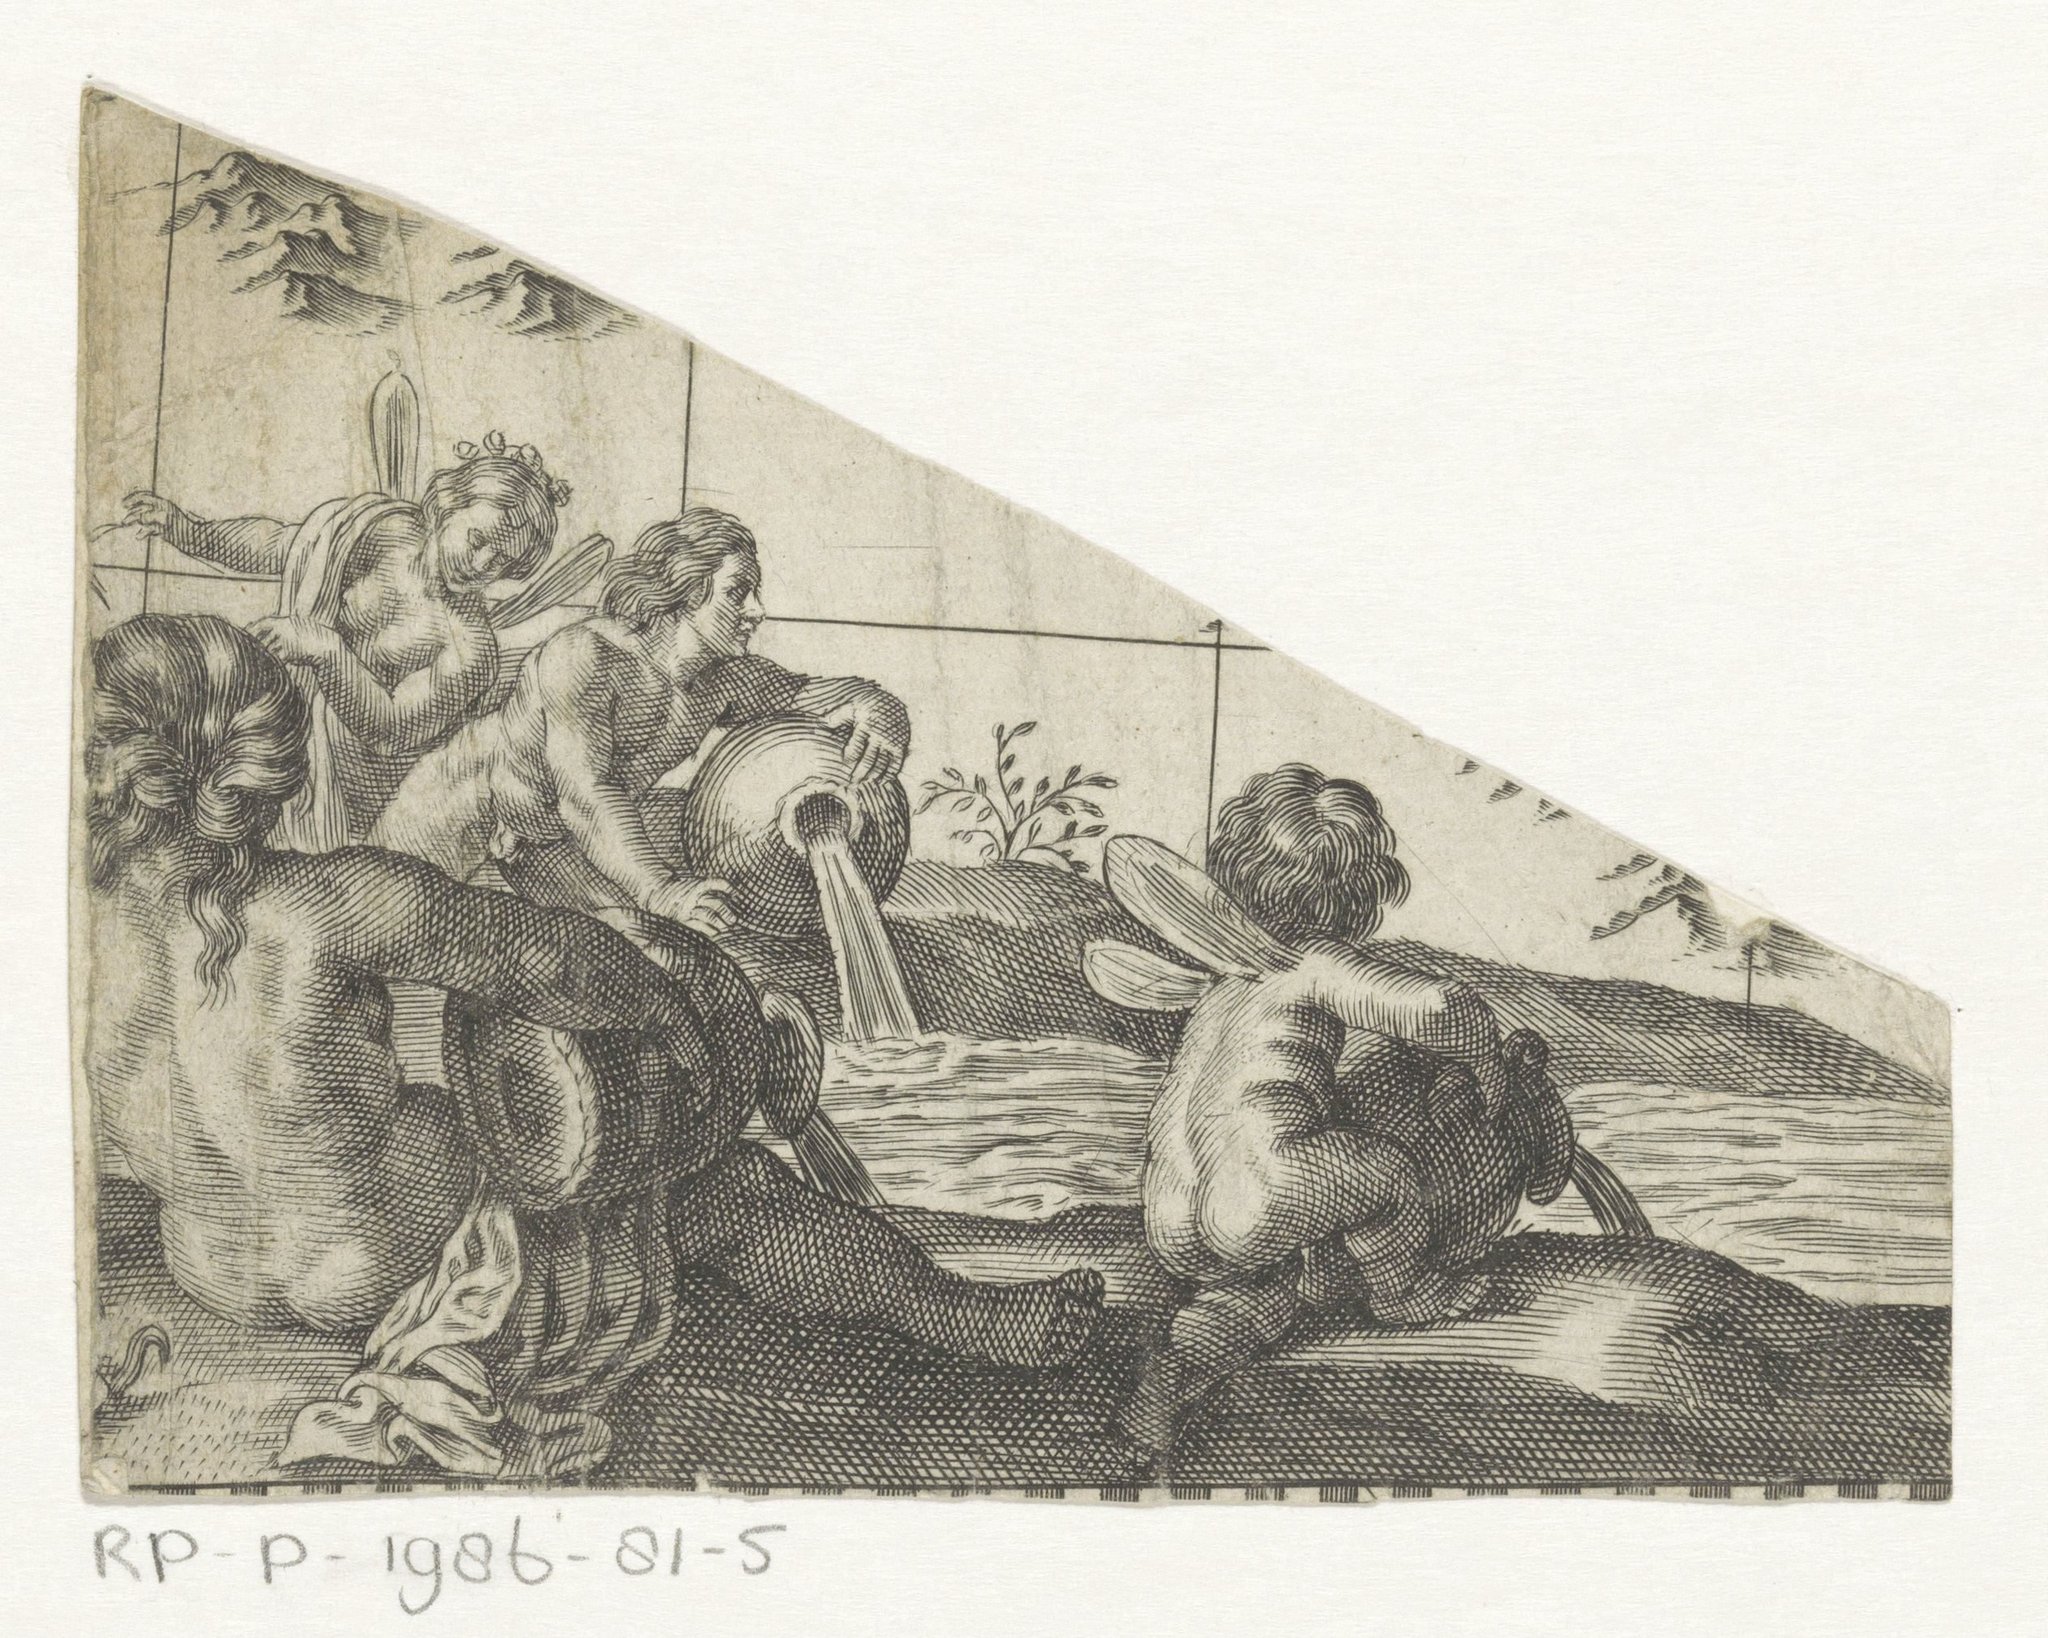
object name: print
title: Riviergoden en putto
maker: Anonymous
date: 1700-1800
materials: paper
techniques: engraving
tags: river-gods, cupids: 'amores', 'amoretti', 'putti'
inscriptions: collector's mark: Lugt 2228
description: Langs een rivier zitten twee riviergoden en een putto met waterkruiken. Links zit een gevleugelde vrouw. Detail van een onbekende kaart.